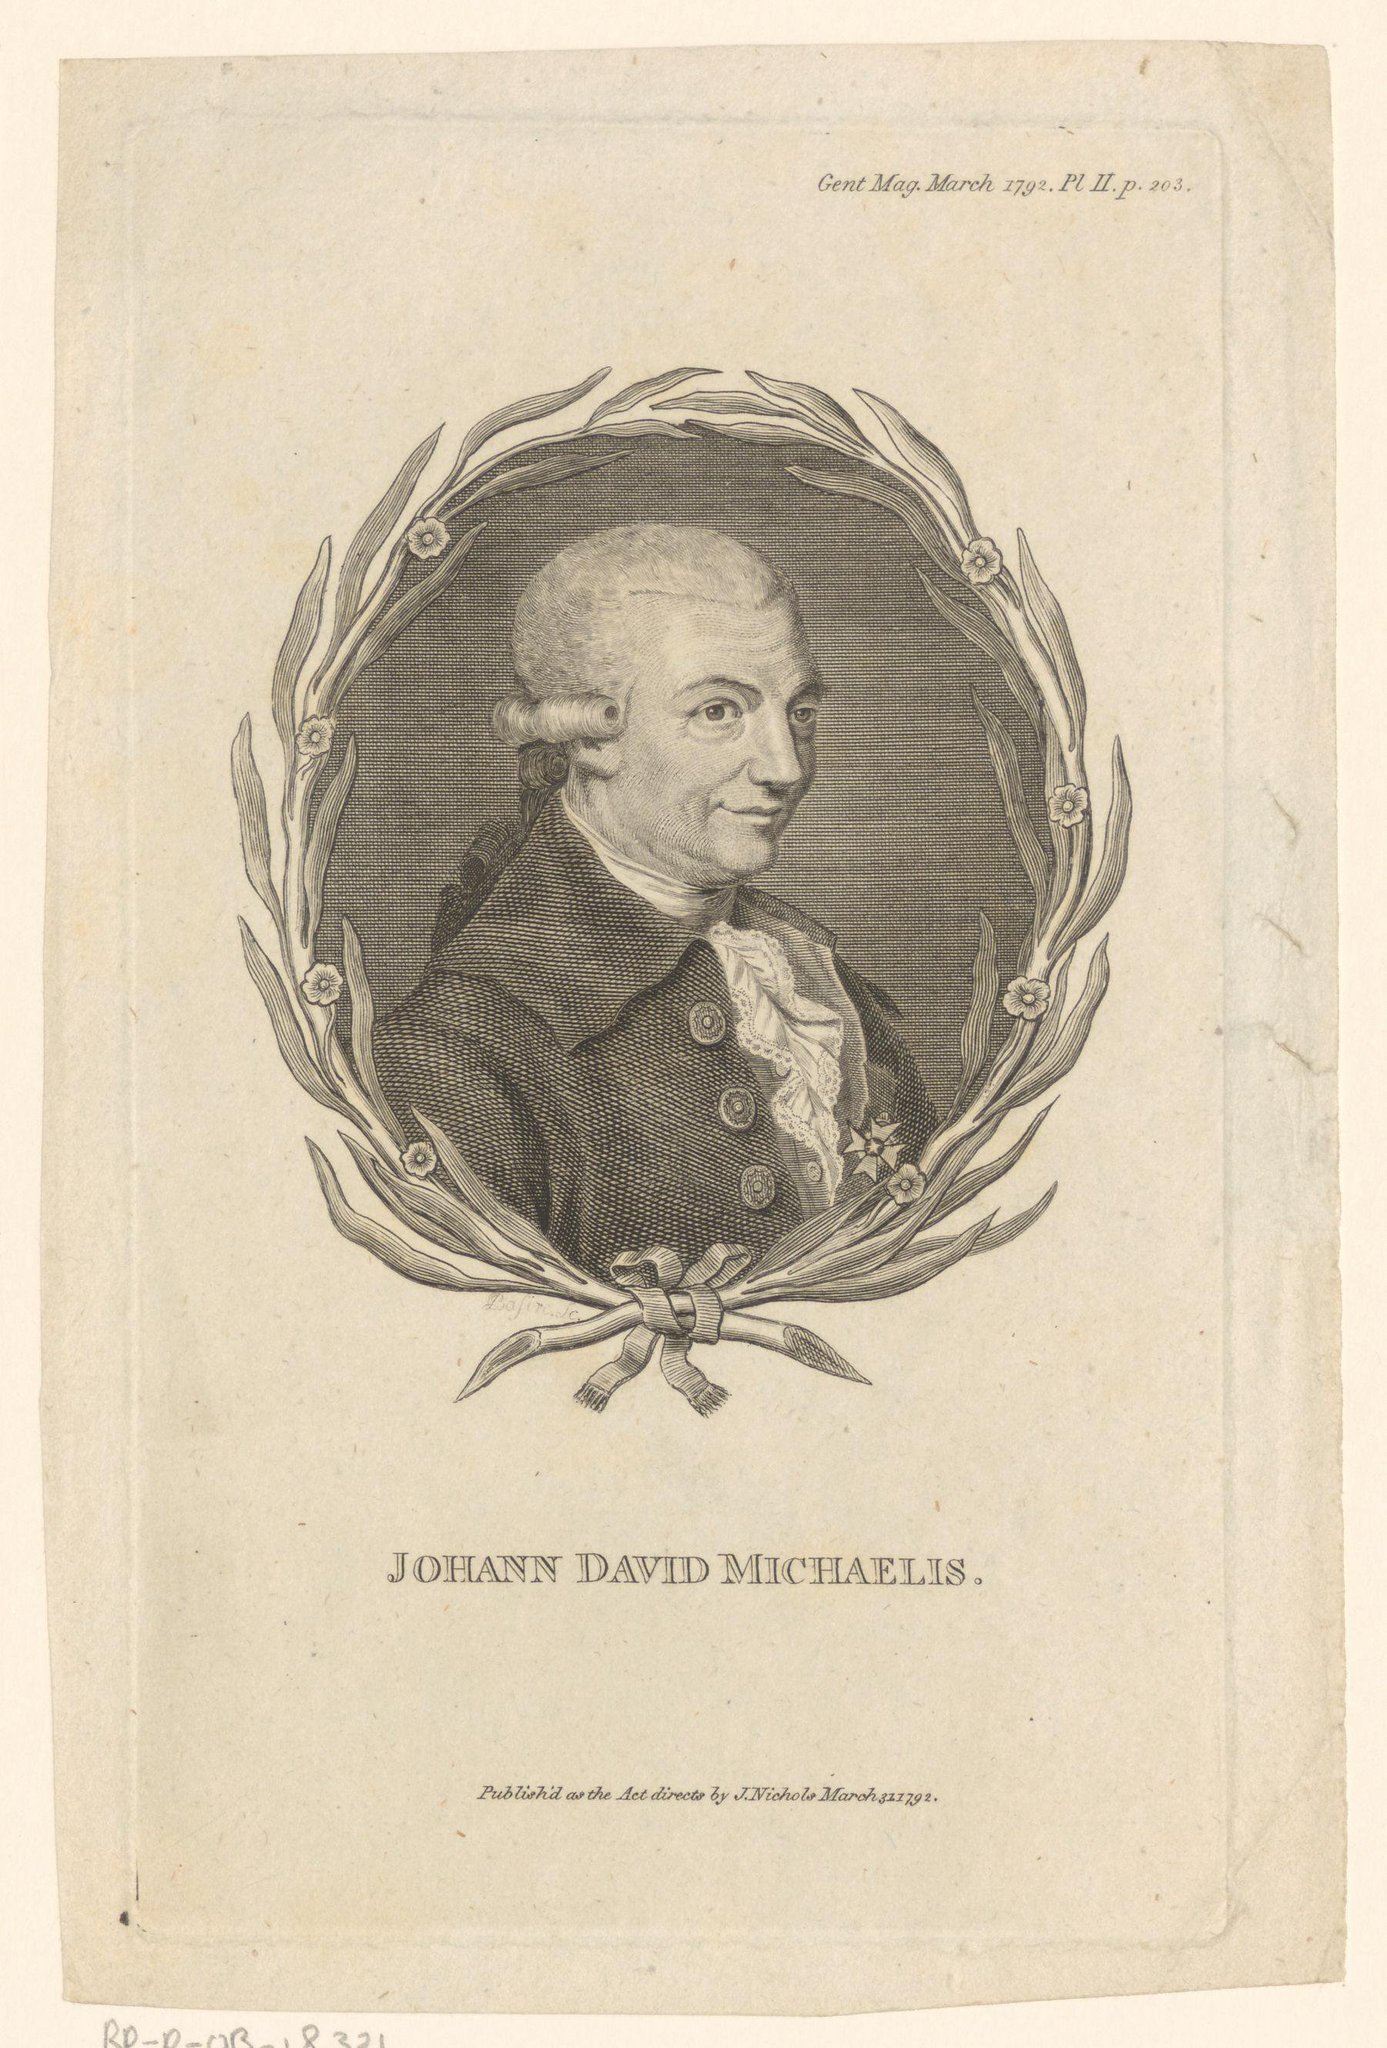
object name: print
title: Johann David Michaelis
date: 1703-1792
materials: paper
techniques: engraving, etching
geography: london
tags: scholar, philosopher, historical persons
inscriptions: collector's mark: Lugt 2228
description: Prent uit: The Gentleman's Magazine, maart 1792, p. 203.